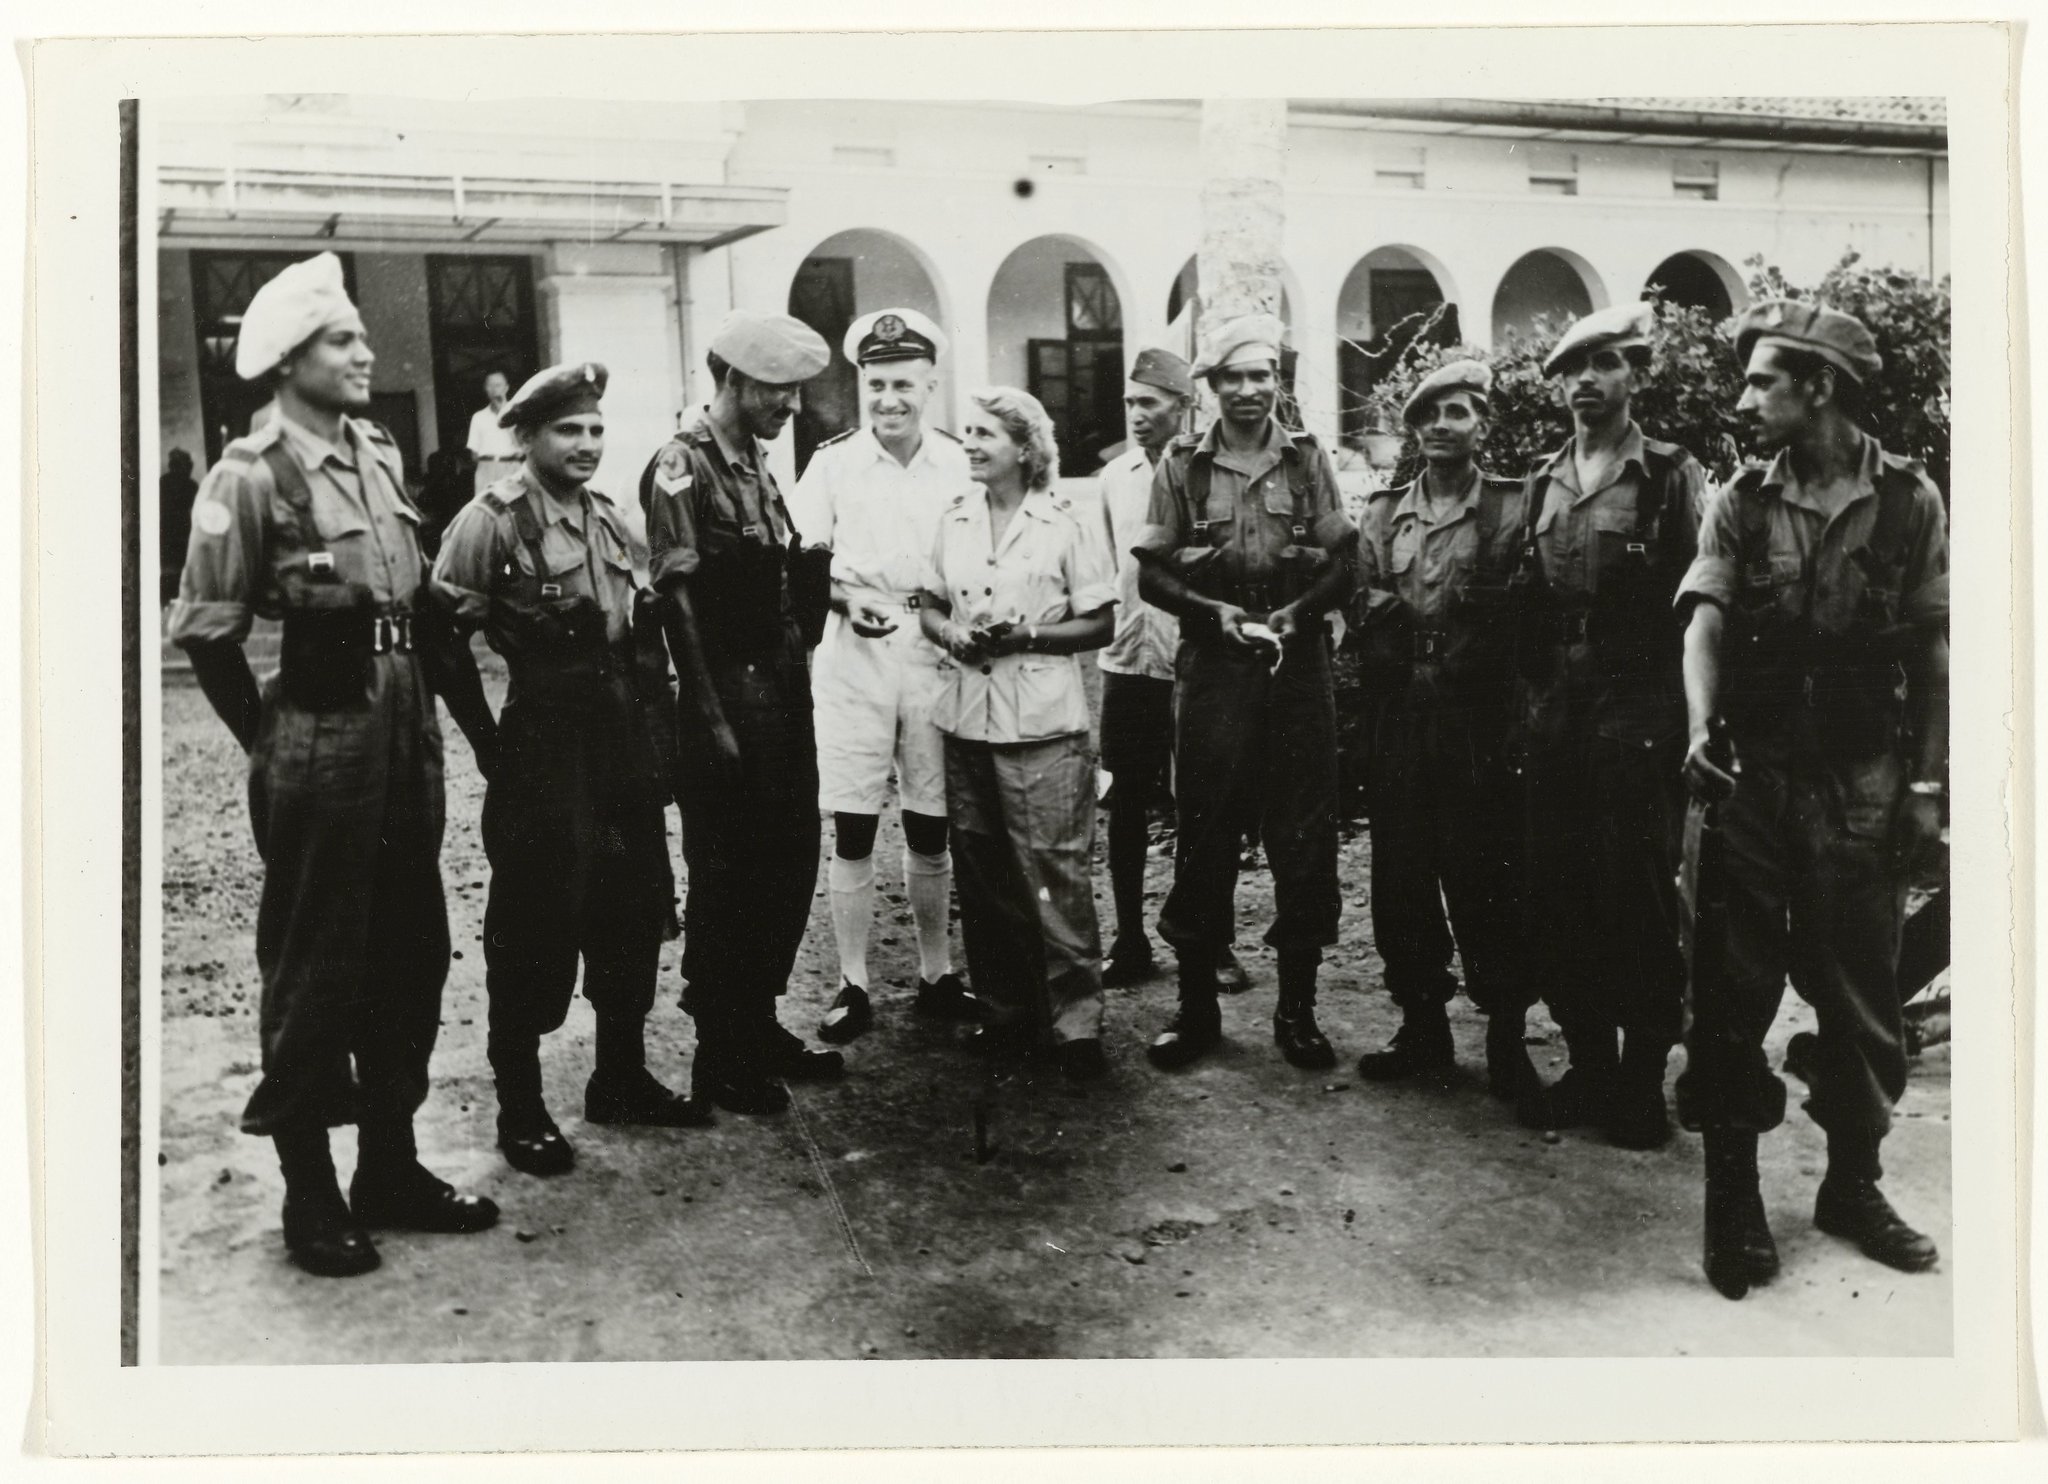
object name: photograph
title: Militairen voor het Maria Dela Rosa-ziekenhuis te Batavia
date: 1945-1946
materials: photographic support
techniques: photography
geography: batavia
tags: batavia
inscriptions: stamp: ‘COPYRIGHT / 'ANEFO' / ALGEMEEN NEDERLANDSCH FOTOBUREAU’, inscription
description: Engelse en Nederlandse militairen voor het Maria Dela Rosa-ziekenhuis te Batavia.